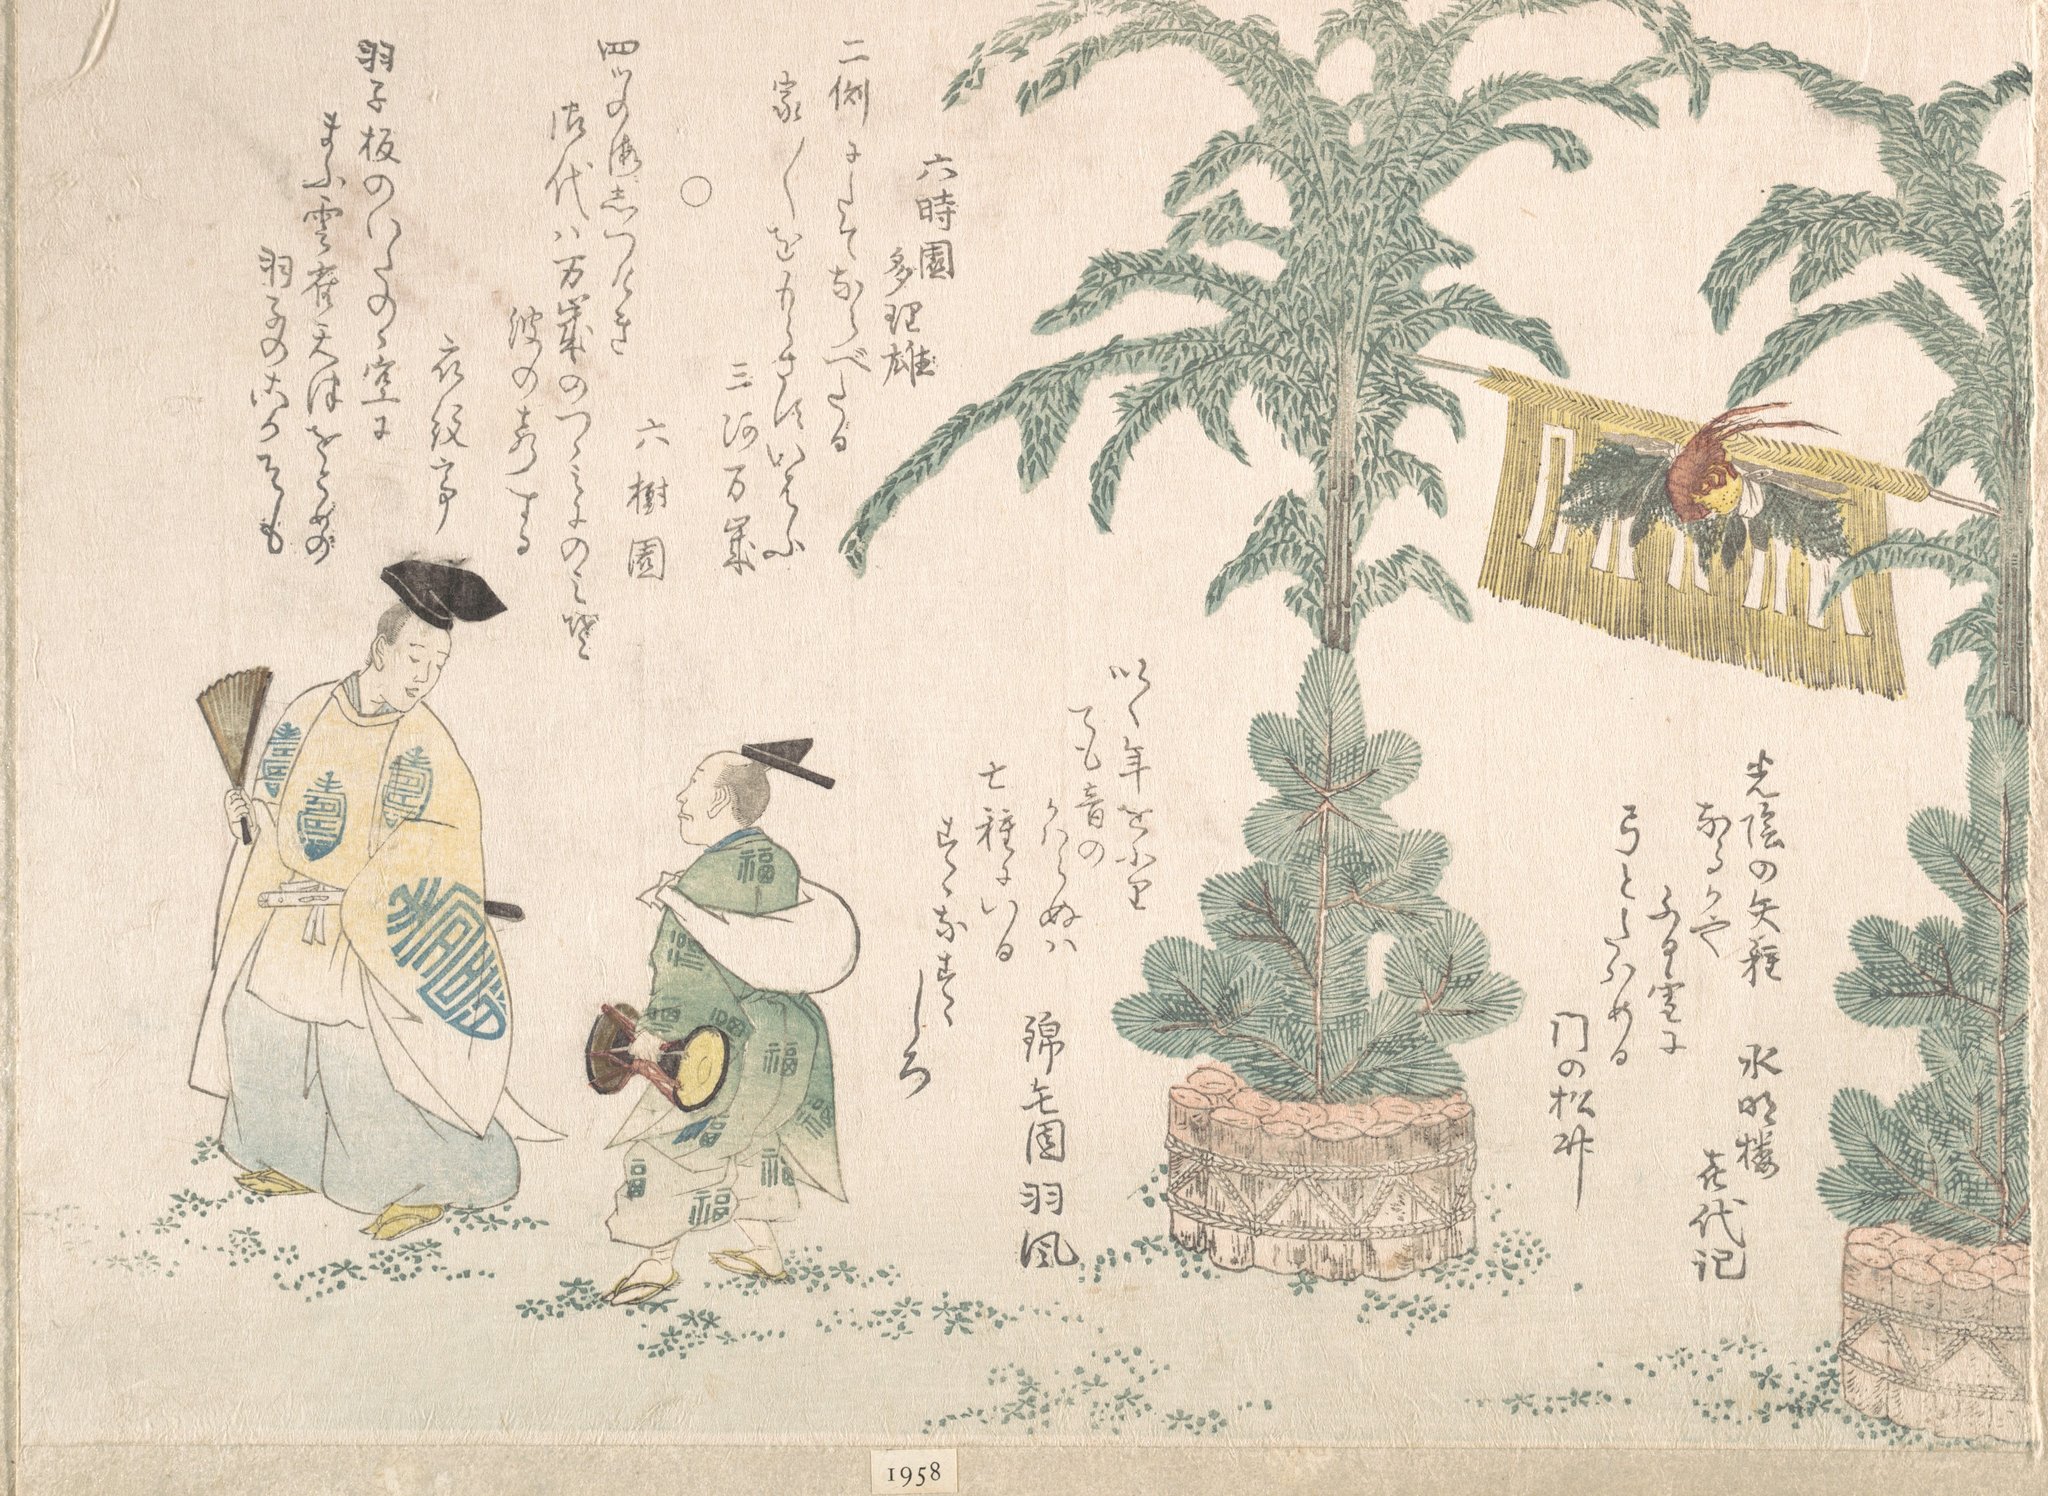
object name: print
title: New Year's Decoration of Pine Trees and Manzai Dancers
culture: japanese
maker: ryūryūkyo shinsai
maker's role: artist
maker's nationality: japanese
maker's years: 1799-1823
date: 1801-1900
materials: ink, paper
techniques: surimono, woodblock print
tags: men,trees,dancers